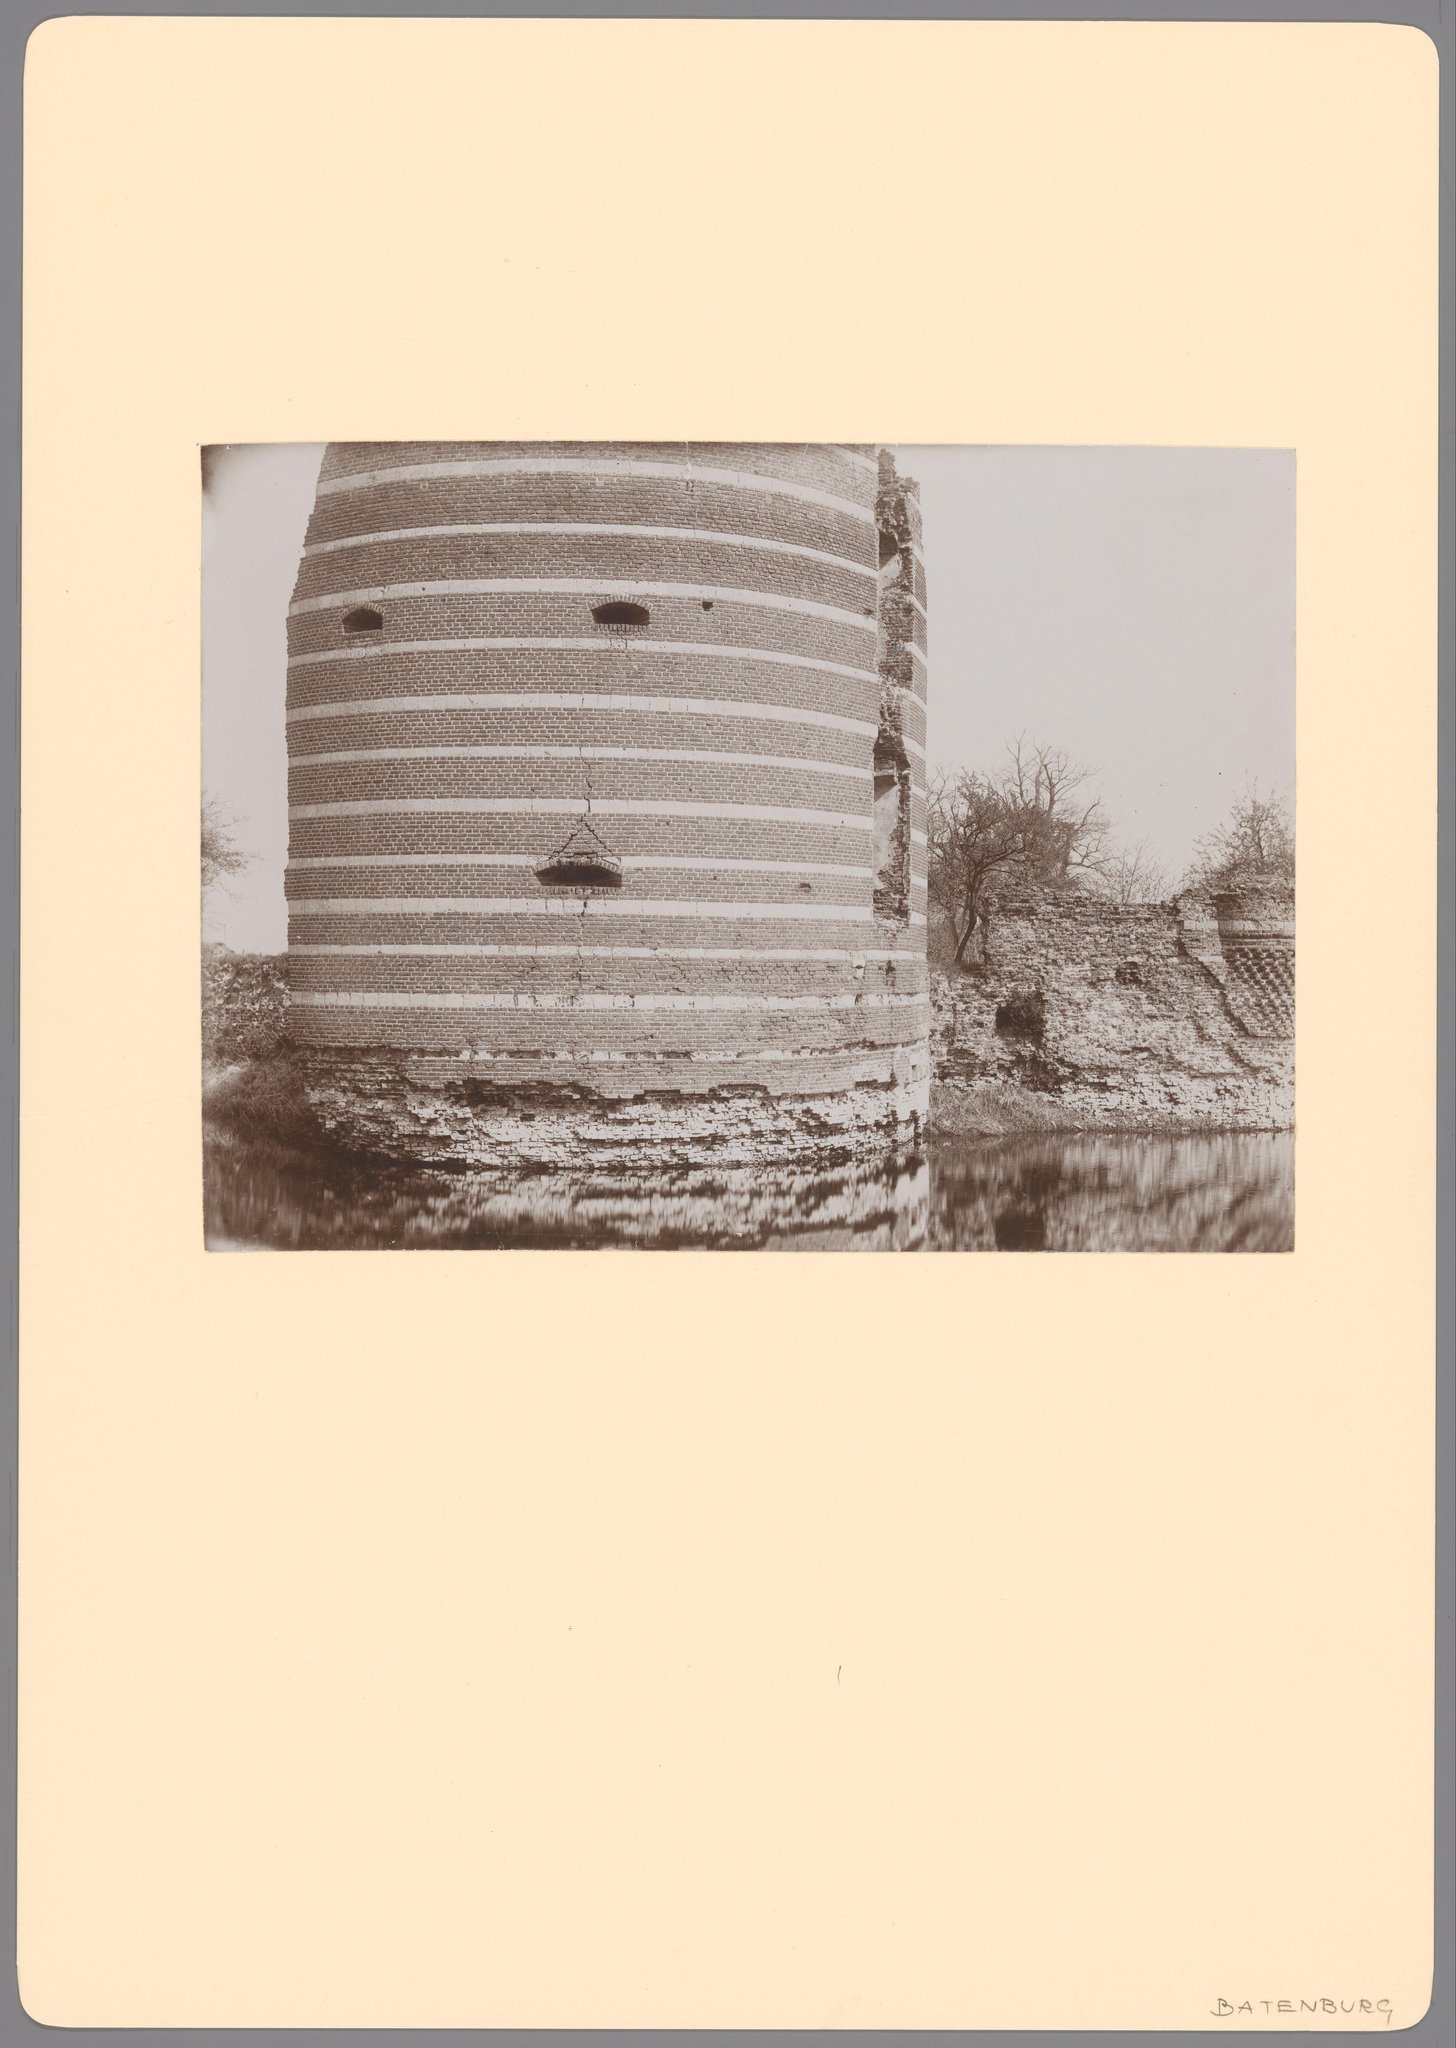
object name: photograph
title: Gedeelte van de kasteelruïne te Batenburg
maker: anoniem (monumentenzorg)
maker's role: fotograaf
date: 1906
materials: cardboard, photographic support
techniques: collodion silver print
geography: batenburg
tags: moat ~ fortified city, ruin of a dwelling, house, castle, etc.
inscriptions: annotation: ‘Kasteel Batenburg (G.)’, annotation: ‘Batenburg’